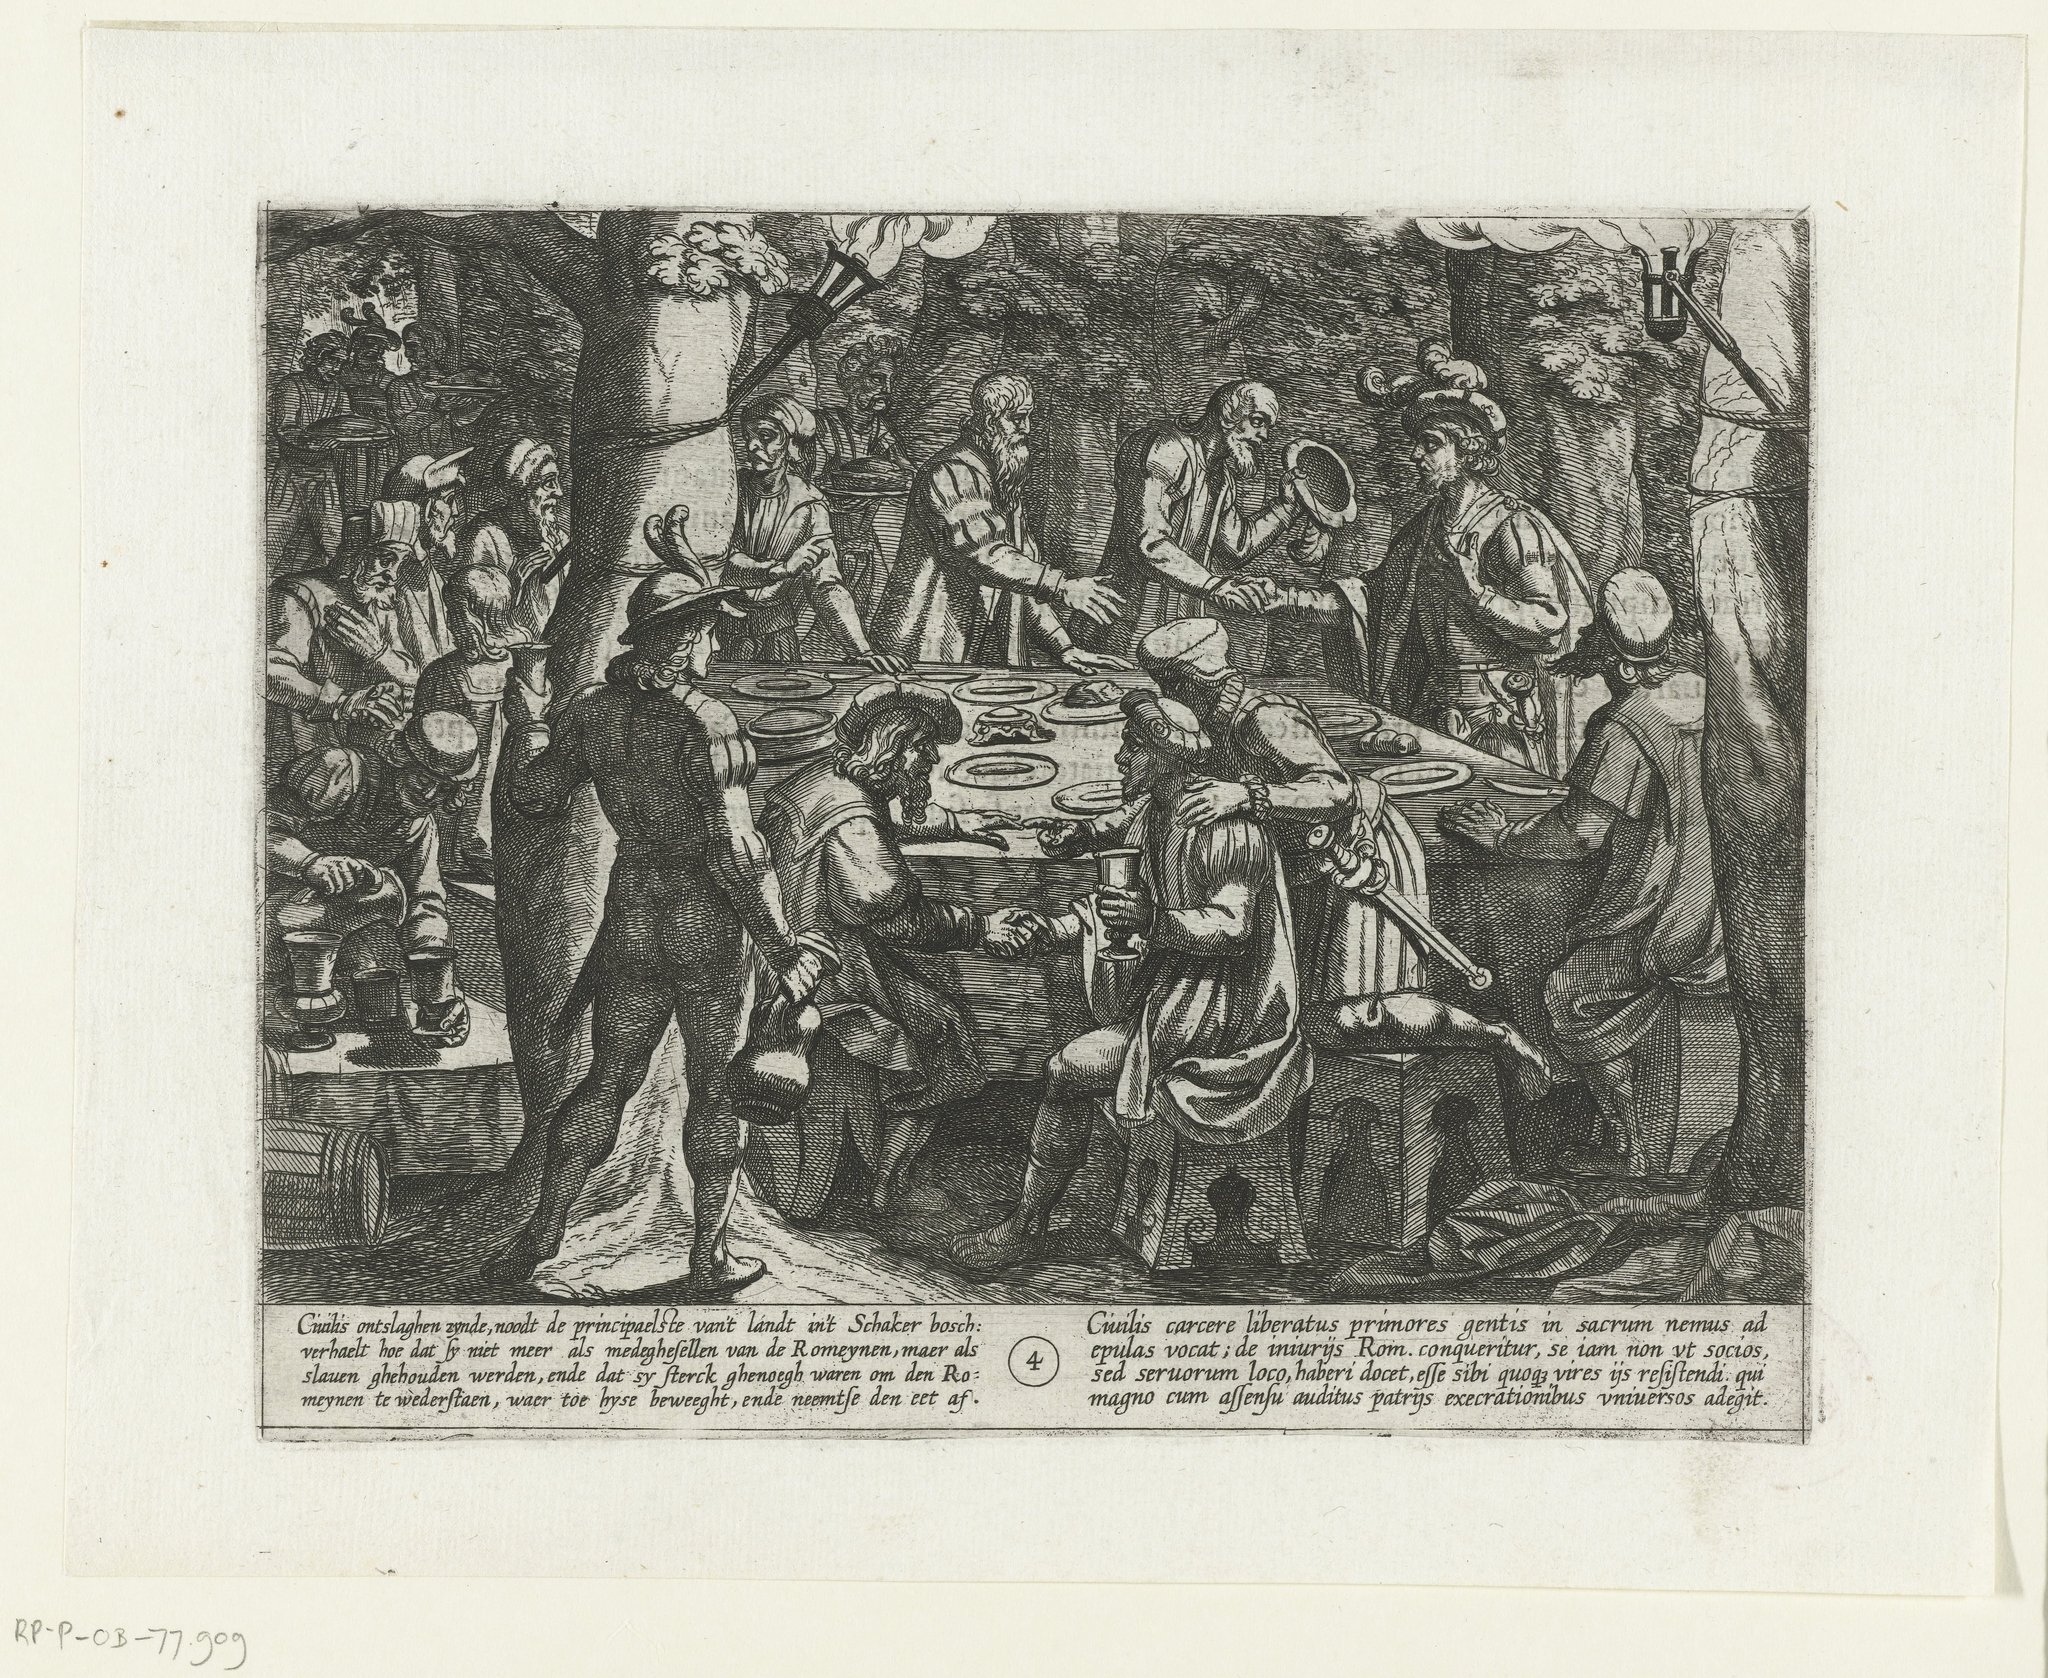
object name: history print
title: Samenzwering van Julius Civilis, 69-70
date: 1612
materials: paper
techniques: etching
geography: italy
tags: extinct, 'historical' peoples (with name), (story of) julius claudius civilis, netherlands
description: De samenzwering van Julius Civilis in het Schakerbos. Julius Civilis vertelt de ouderlingen tijdens een nachtelijke bijeenkomst in het woud dat zij door de Romeinen als slaafgemaakten worden behandeld. Prent nummer 4 in de serie prenten over de Bataafse Opstand: Batavorum cum Romanis bellum / à Corn. Tacito lib. IV & V. : Hist. olim descriptum, figuris nunc aeneis expressum, auctore Othone Vaenio Lugdunobatava = De Batavische oft oude Hollandtsche oorloghe teghen de Romeynen. Otto Vaenius, Antwerpen 1612. Onderaan twee verzen van vier regels in het Nederlands en in het Latijn. Op de achterzijde tekst in het Latijn.